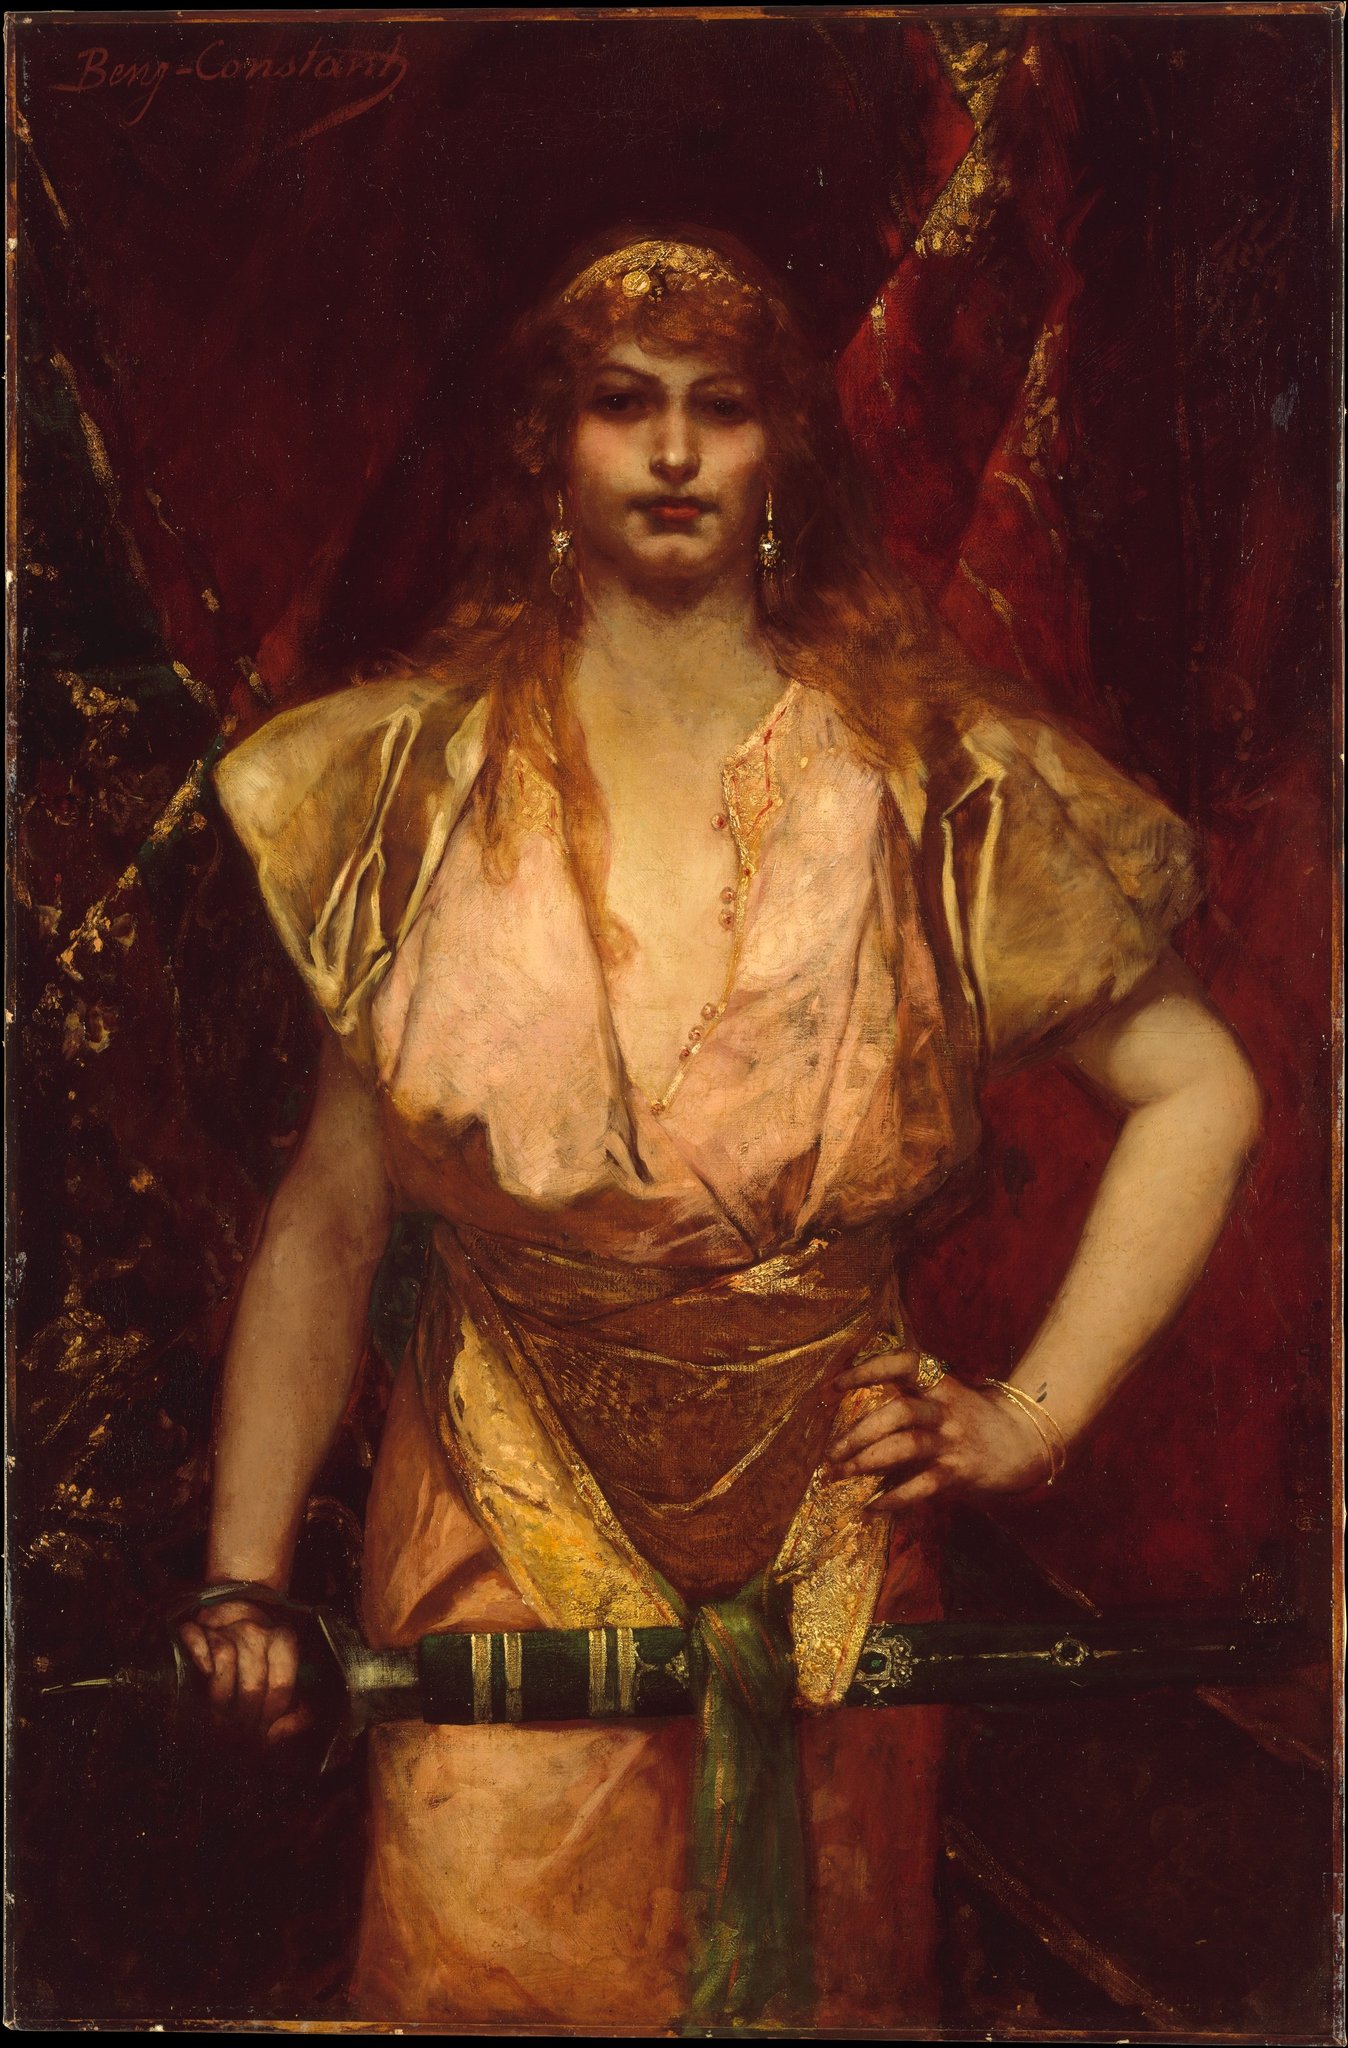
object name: painting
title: Judith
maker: benjamin-constant (jean-joseph-benjamin constant)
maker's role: artist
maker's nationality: french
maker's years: 1845-1902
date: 1886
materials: canvas, oil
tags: swords,judith